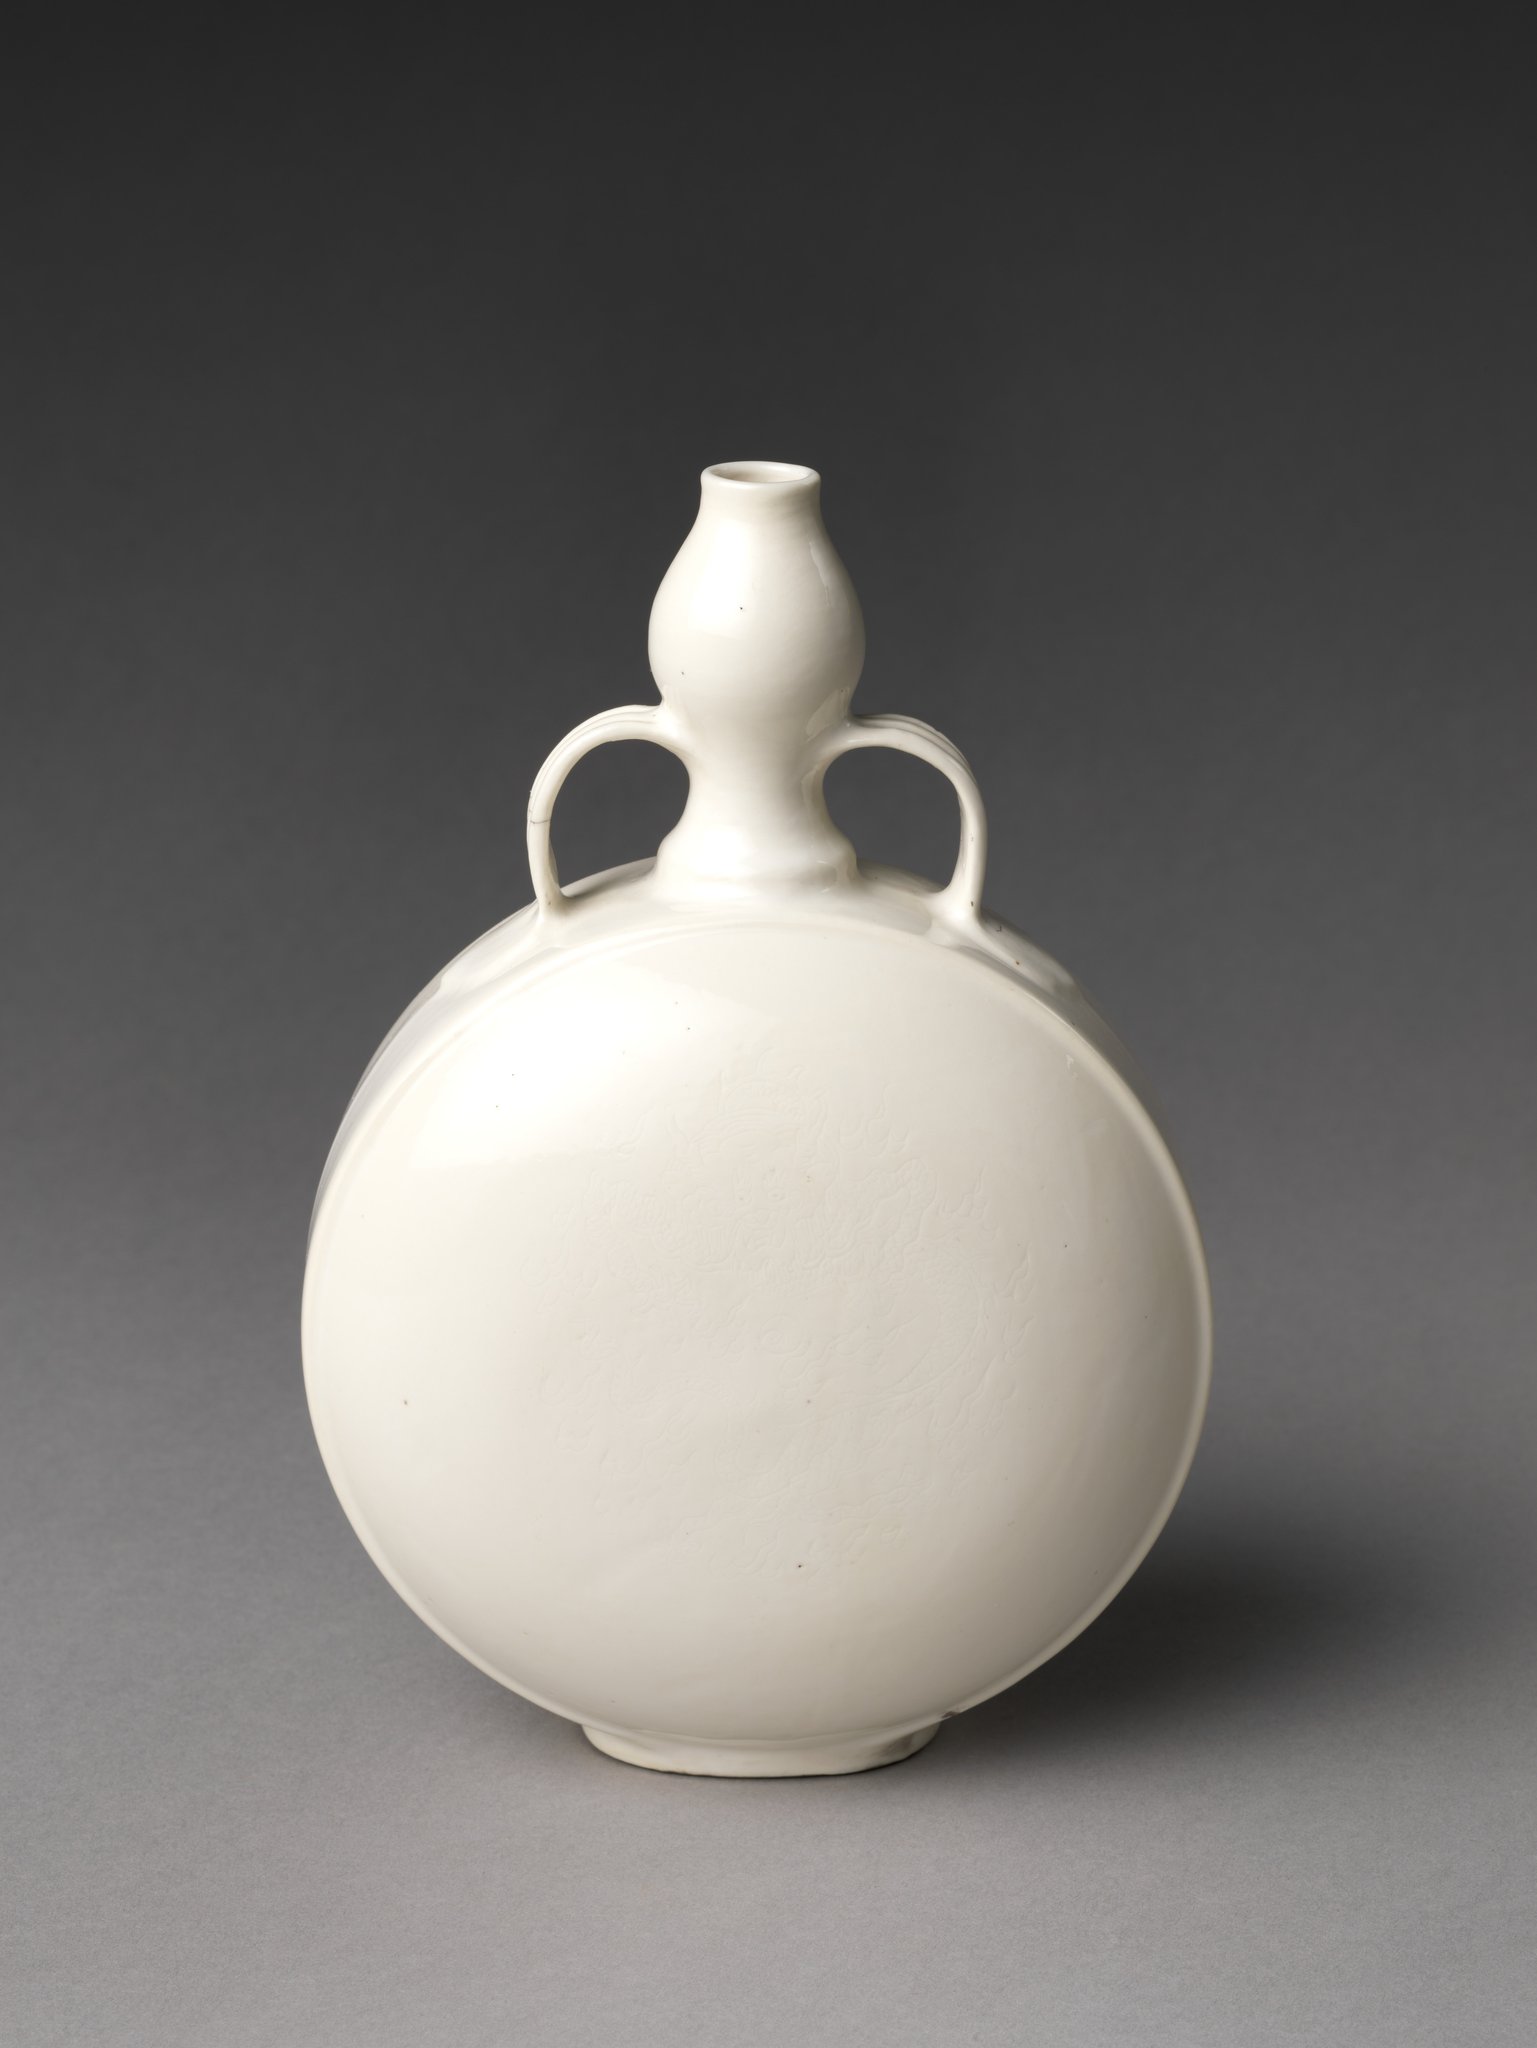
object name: bottle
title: Moon-Shaped Bottle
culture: chinese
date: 1701-1800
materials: glaze, ivory, soft paste porcelain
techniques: incising